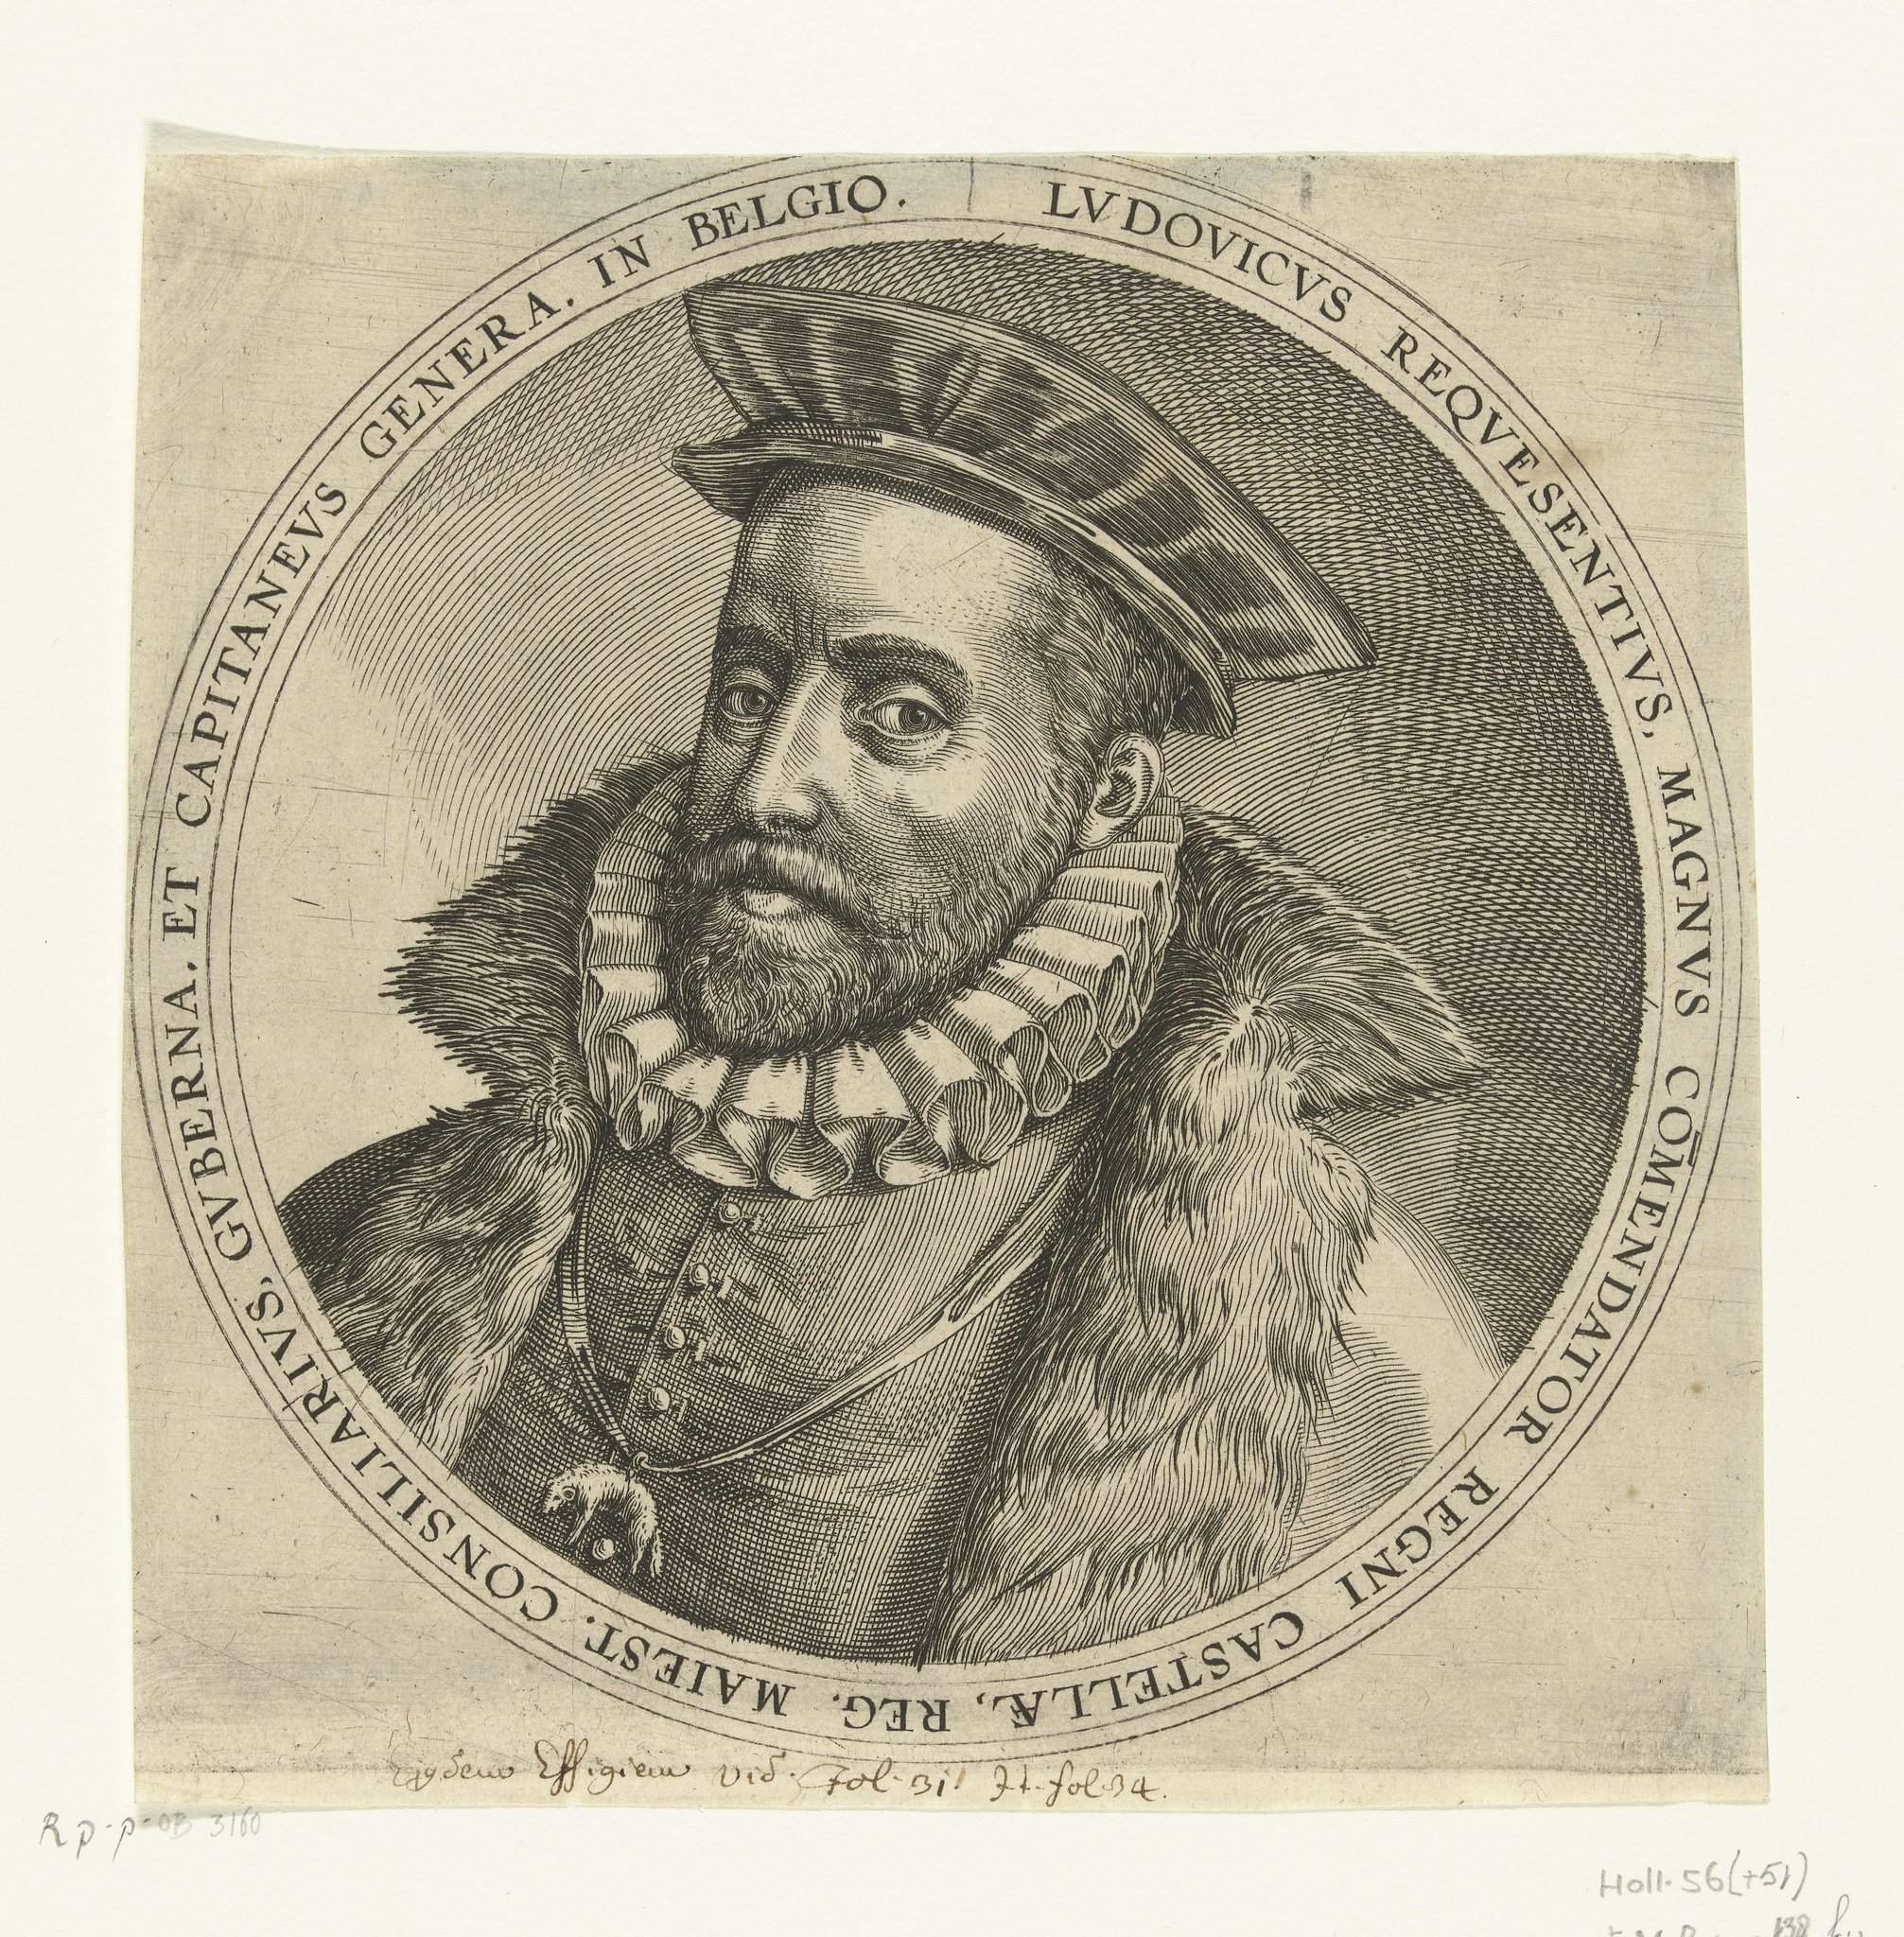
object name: print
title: Portret van Luis de Requesens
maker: frans hogenberg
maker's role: print maker, publisher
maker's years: 1538-1590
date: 1573-1590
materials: paper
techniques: engraving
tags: brussels, mayor, luis de zúñiga y requesens, knighthood order of the golden fleece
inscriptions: caption: ‘LUDOVICUS REQUESENTIUS...IN BELGIO’, collector's mark: Lugt 2228, caption: ‘[...] Effigiem Vis. Fol.31 [...] fol.34’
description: Don Luis de Requesens y Zunega, landvoogd over de Nederlanden. Buste naar links, in ronde lijst, met randschrift in het Latijn. Orde van het Gulden Vlies om de hals. Mantel afgezet met bont. Hoed met smalle rand op het hoofd.